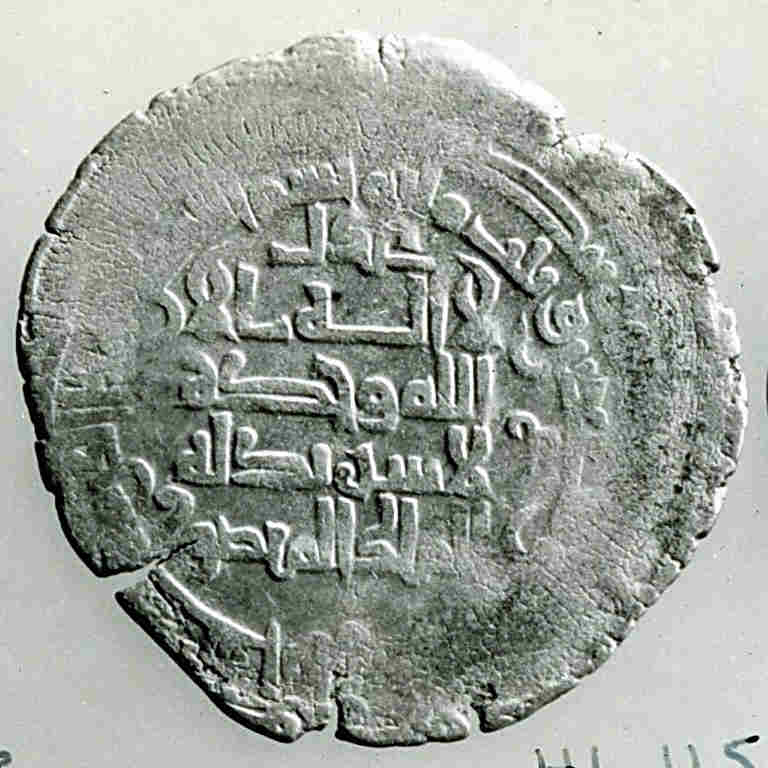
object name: coin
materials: silver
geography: iran